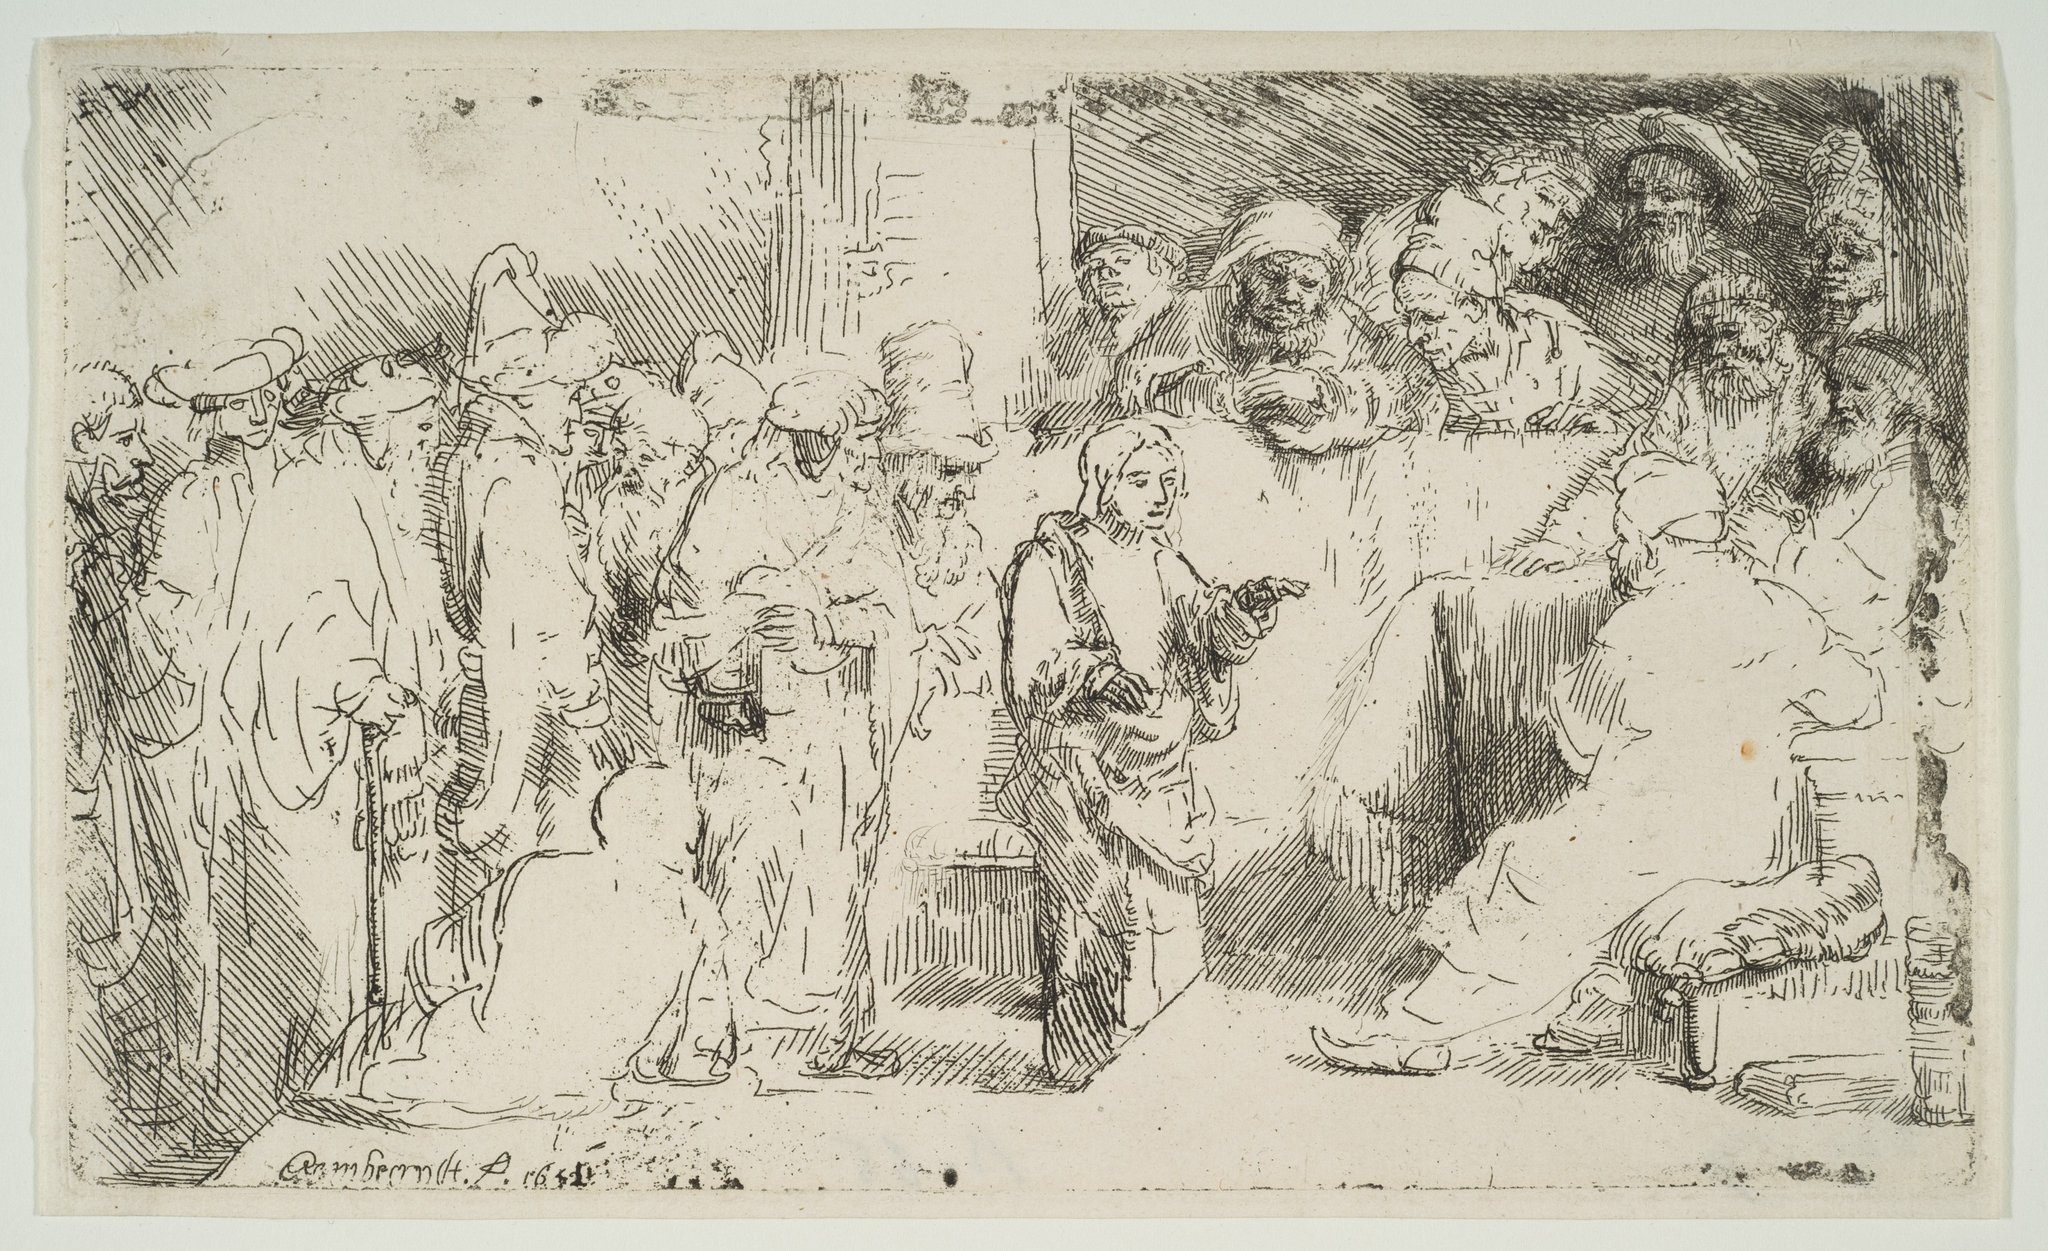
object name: print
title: Christ Disputing with the Doctors; a sketch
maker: rembrandt van rijn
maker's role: artist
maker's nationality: dutch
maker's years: 1606-1669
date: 1652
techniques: drypoint, etching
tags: men,christ,doctors